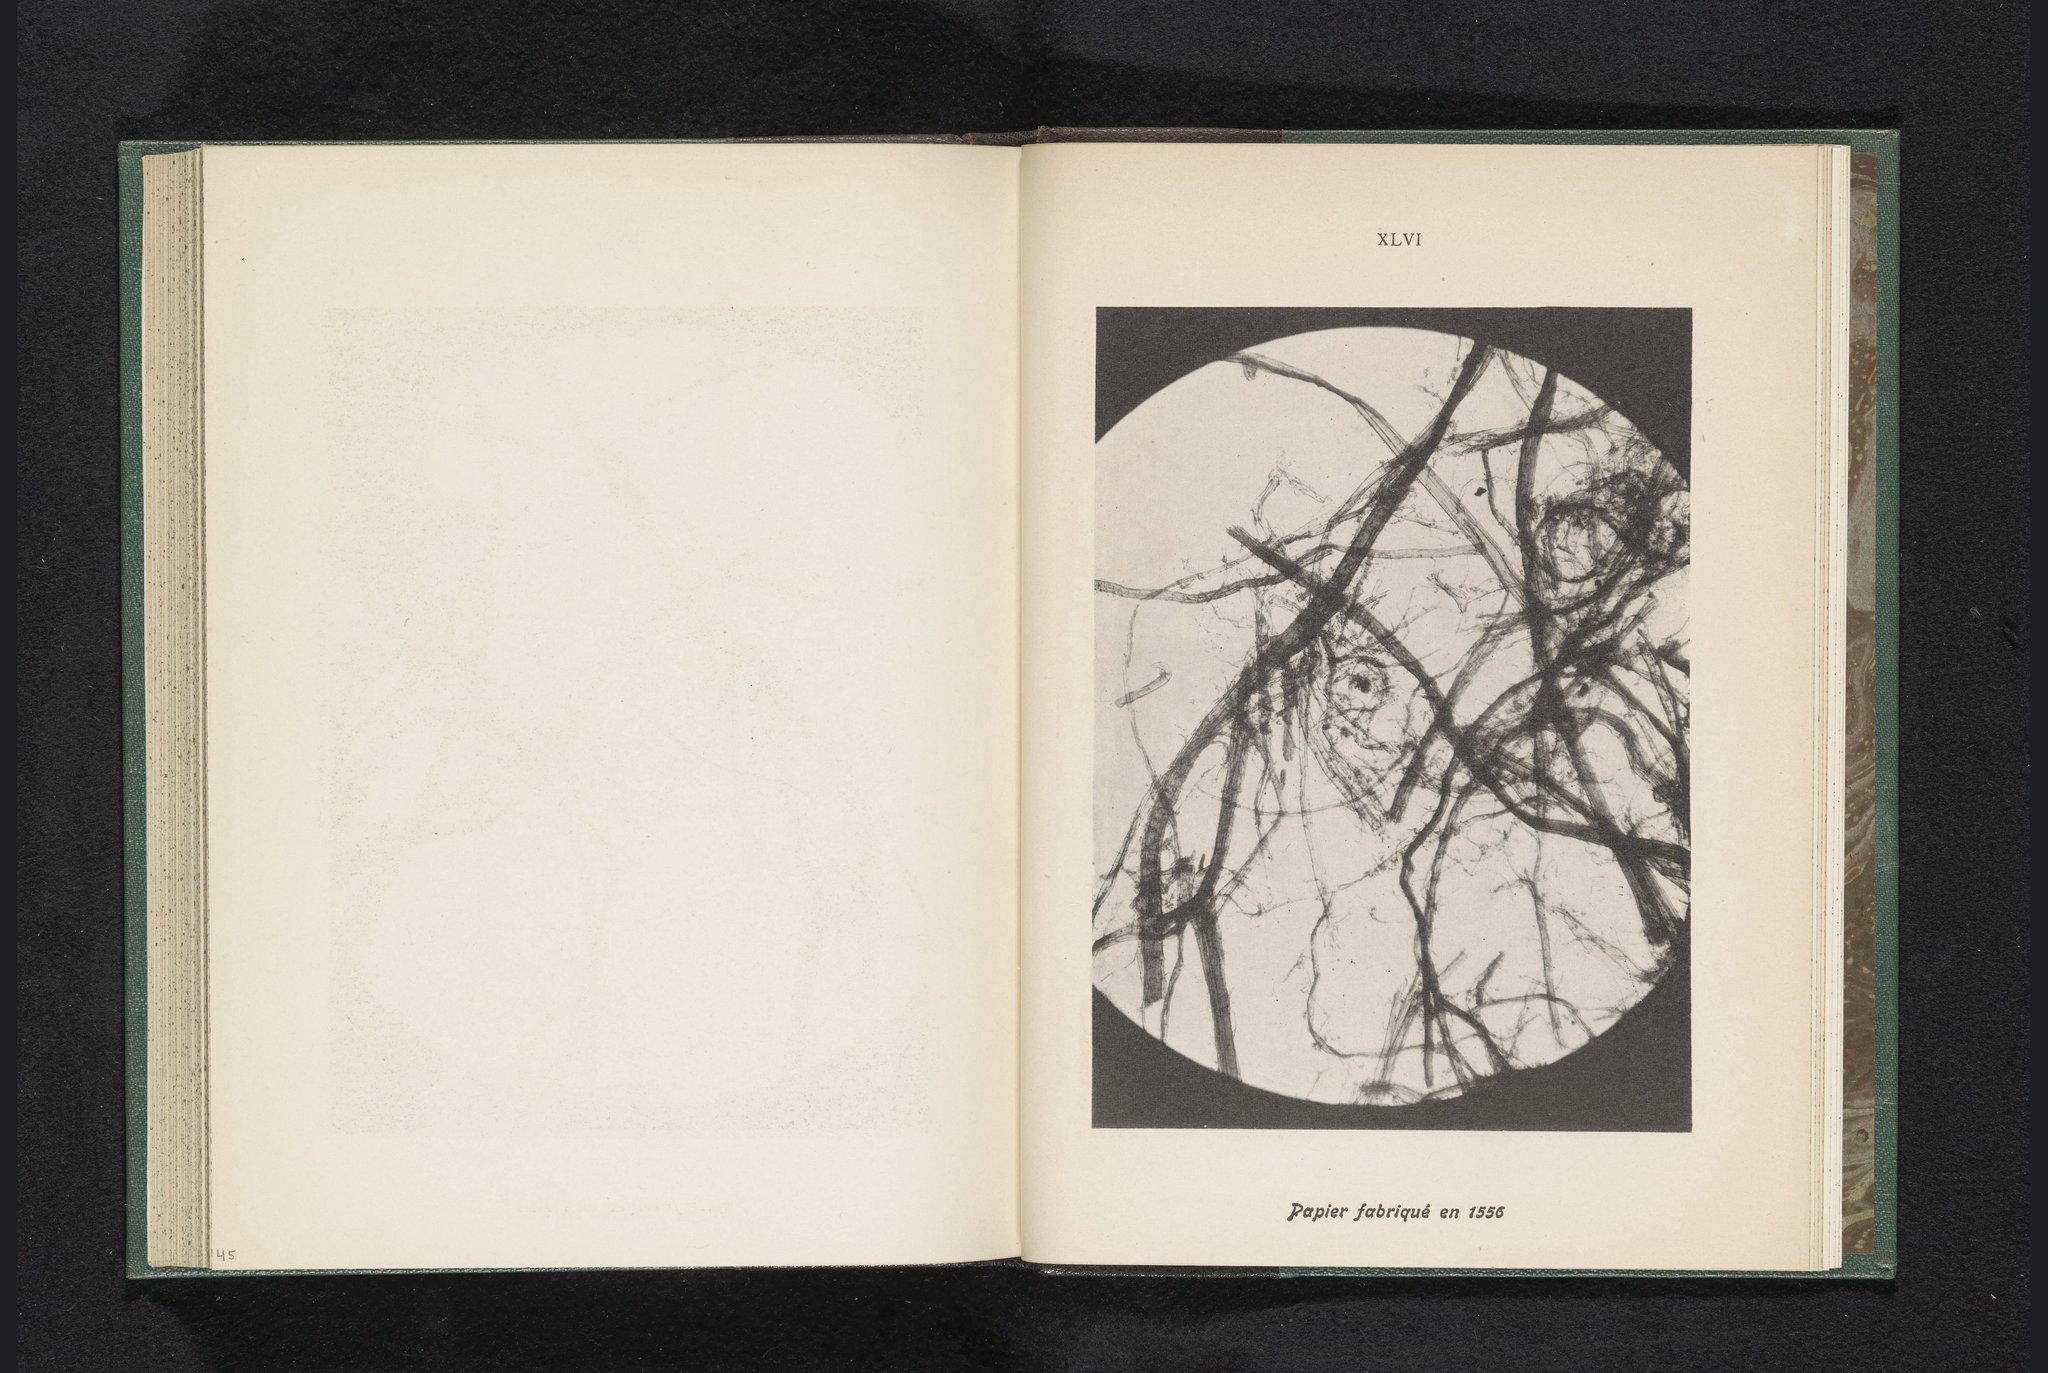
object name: page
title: Papier fabriqué en 1556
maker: Anonymous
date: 1890-1900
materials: paper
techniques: photograph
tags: paper (writing material)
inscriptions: number: ‘XLVI’